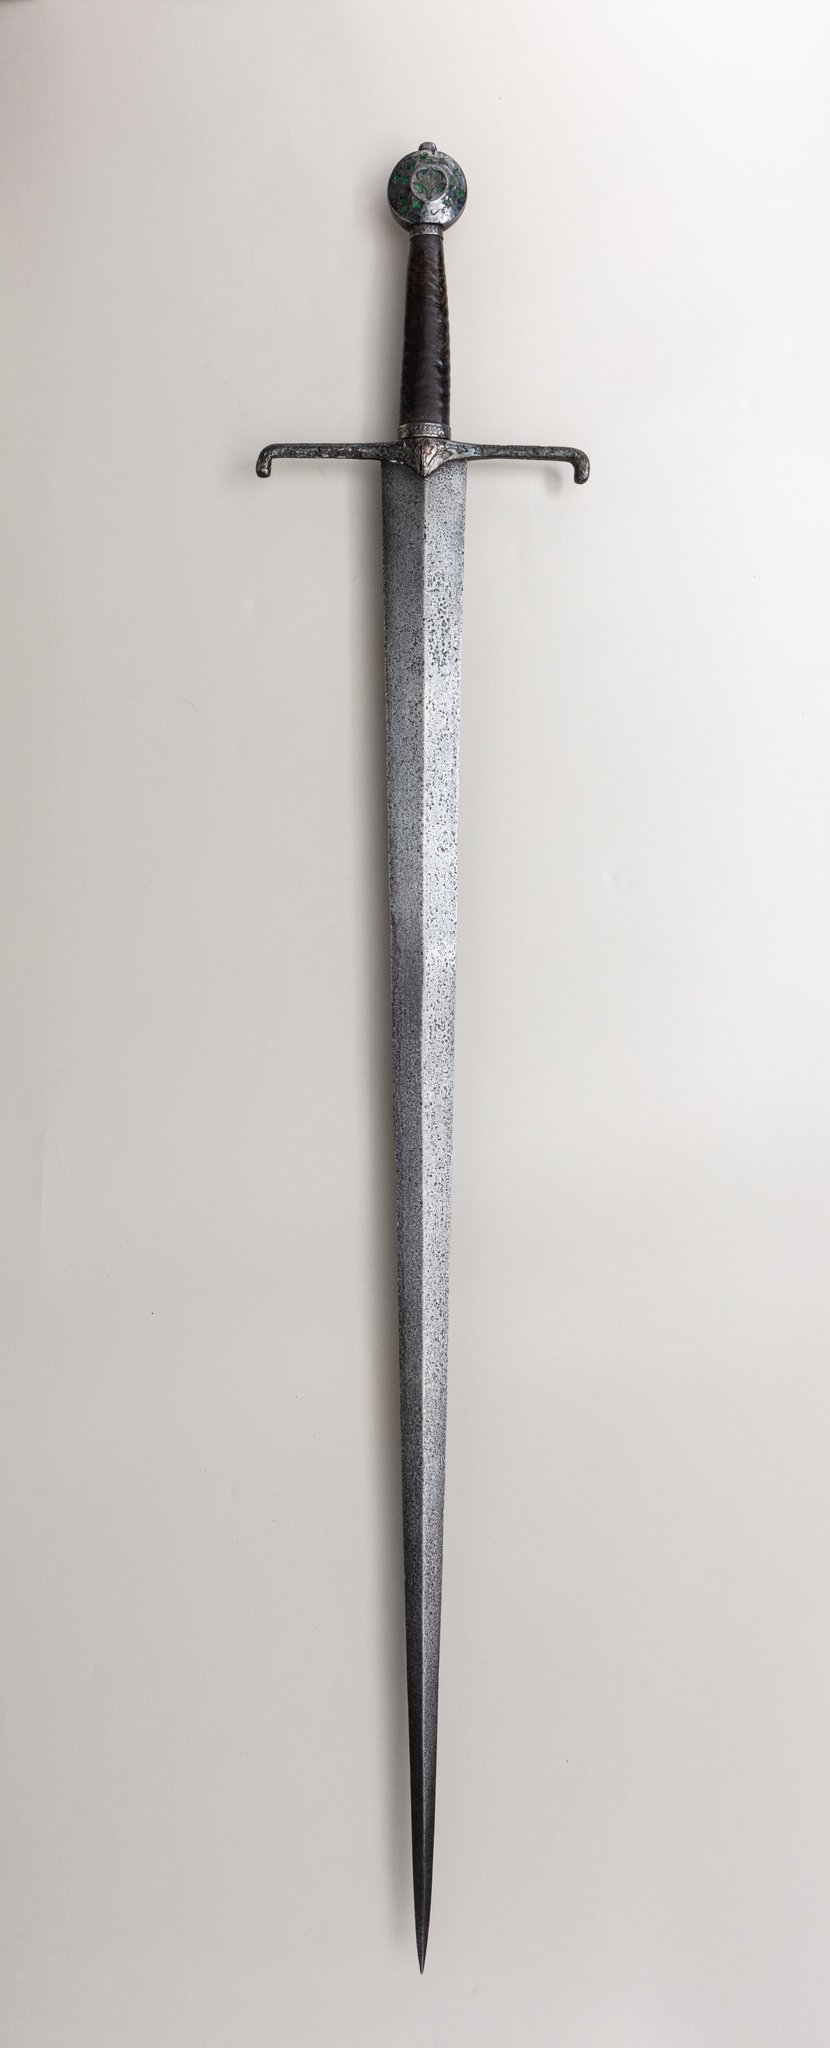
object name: knightly sword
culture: french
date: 1401-1433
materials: enamel, gold, leather, silver, steel, wood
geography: france